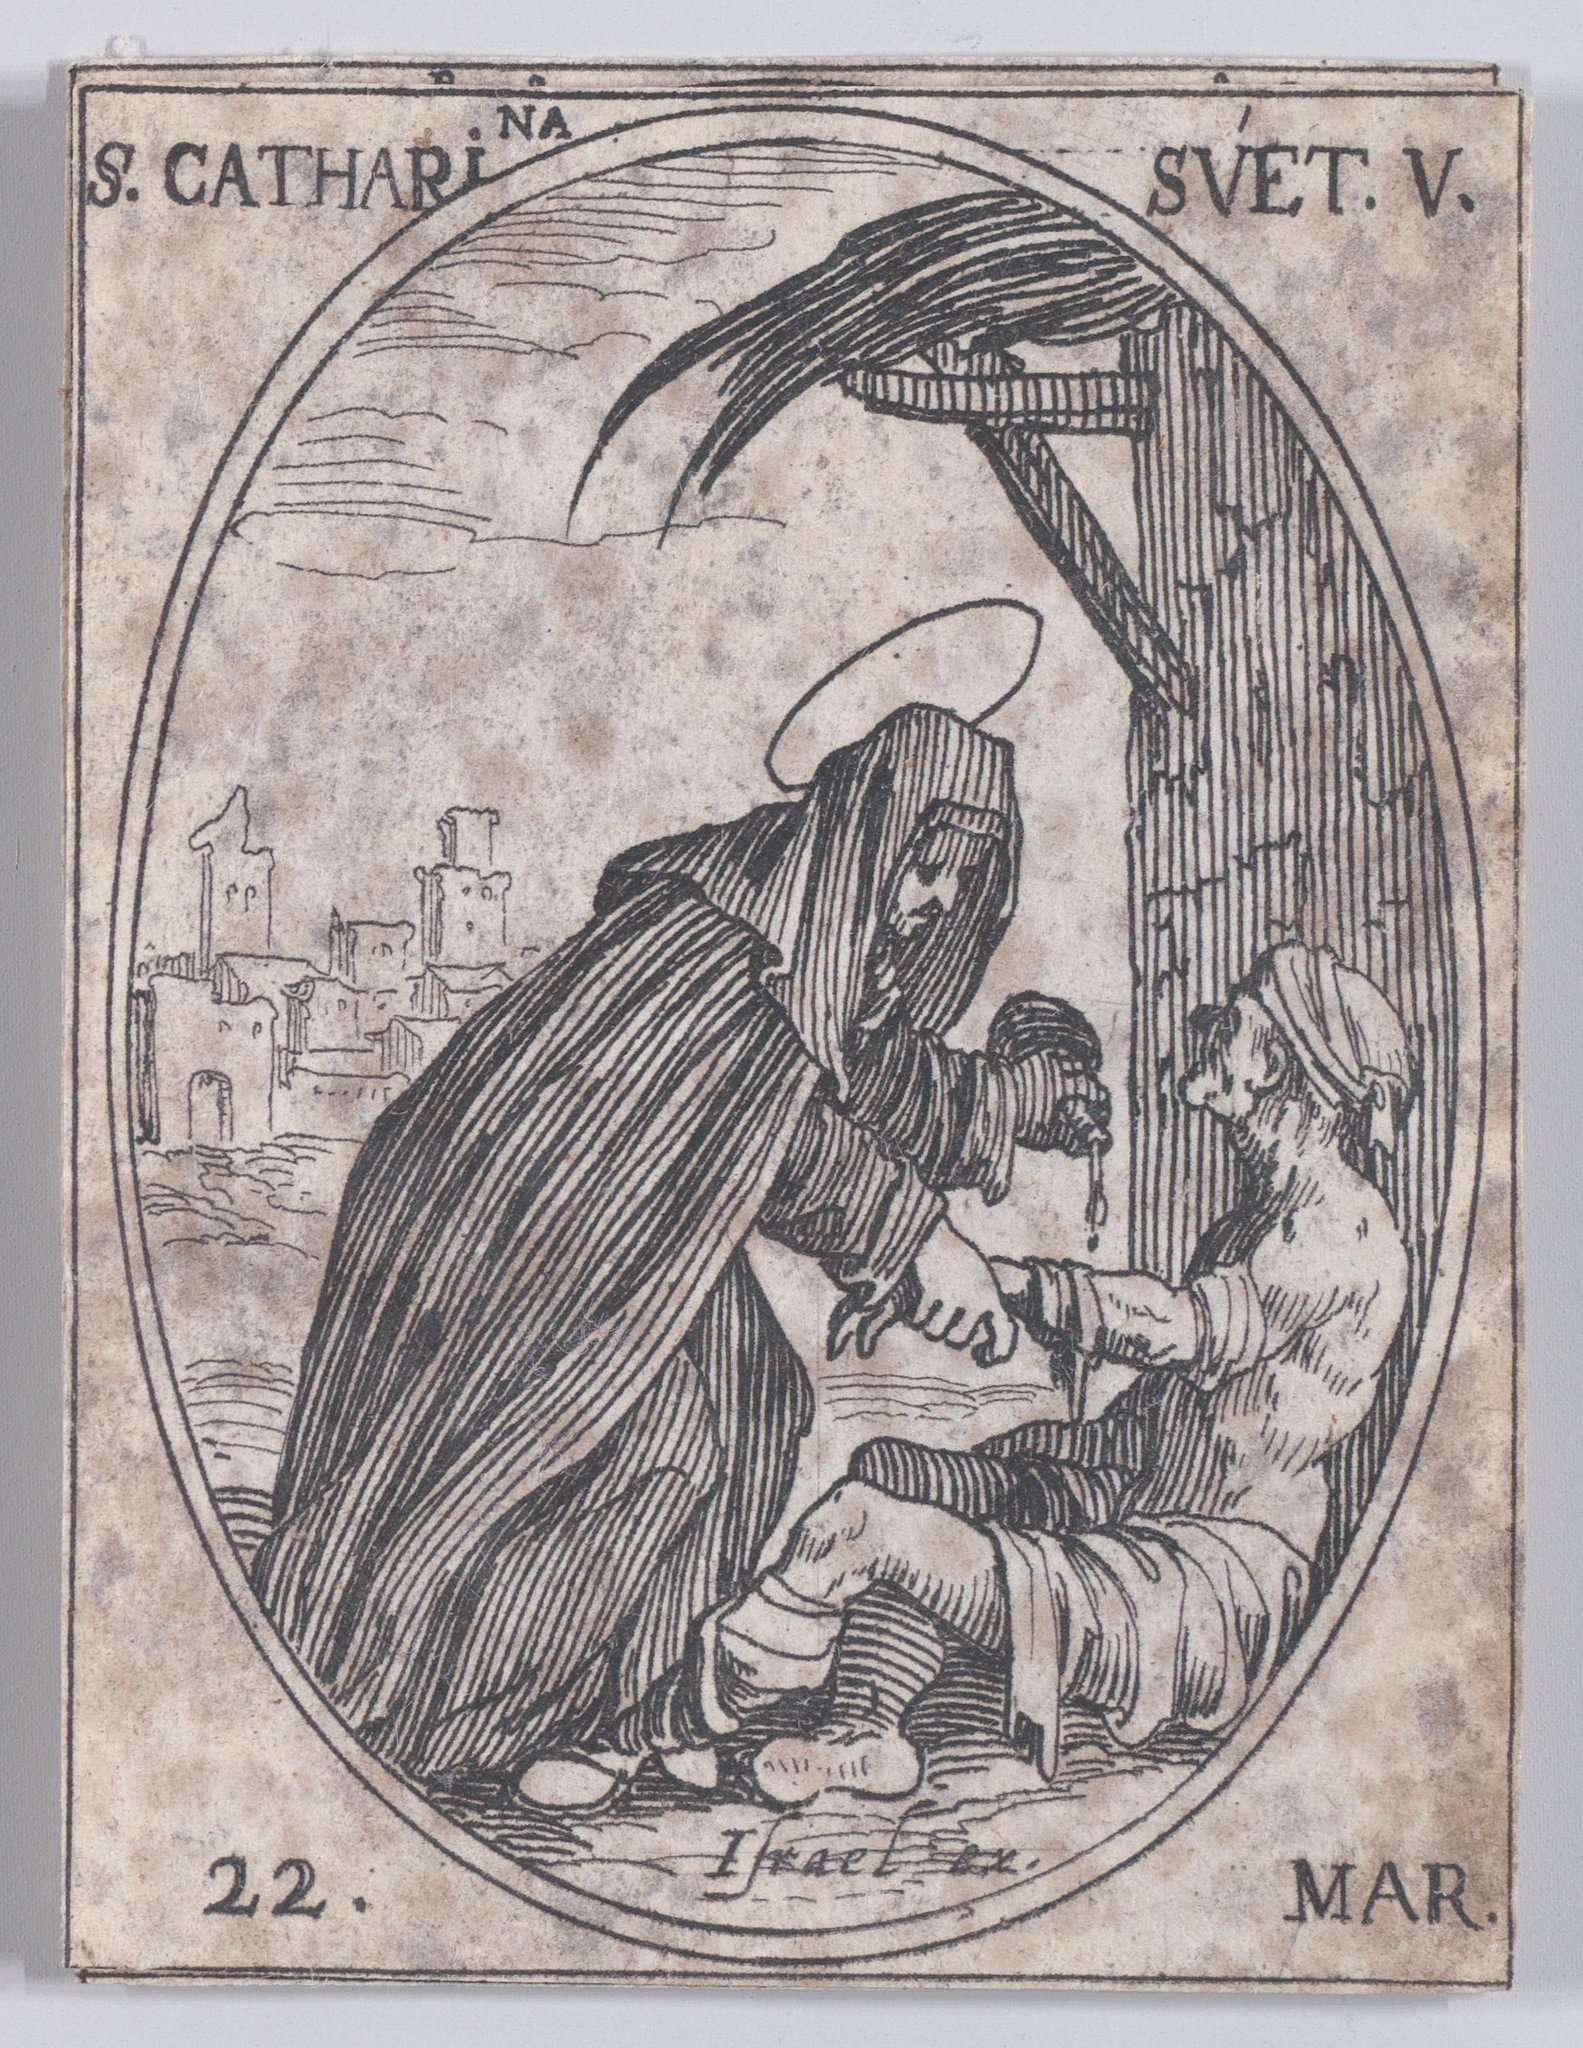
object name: print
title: S. Catharina de Suède (St. Catherine of Sweden), March 22nd, from "Les Images De Tous Les Saincts et Saintes de L'Année" (Images of All of the Saints and Religious Events of the Year)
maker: jacques callot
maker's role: artist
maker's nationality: french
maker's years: 1592-1635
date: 1636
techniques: etching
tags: men,women,saints